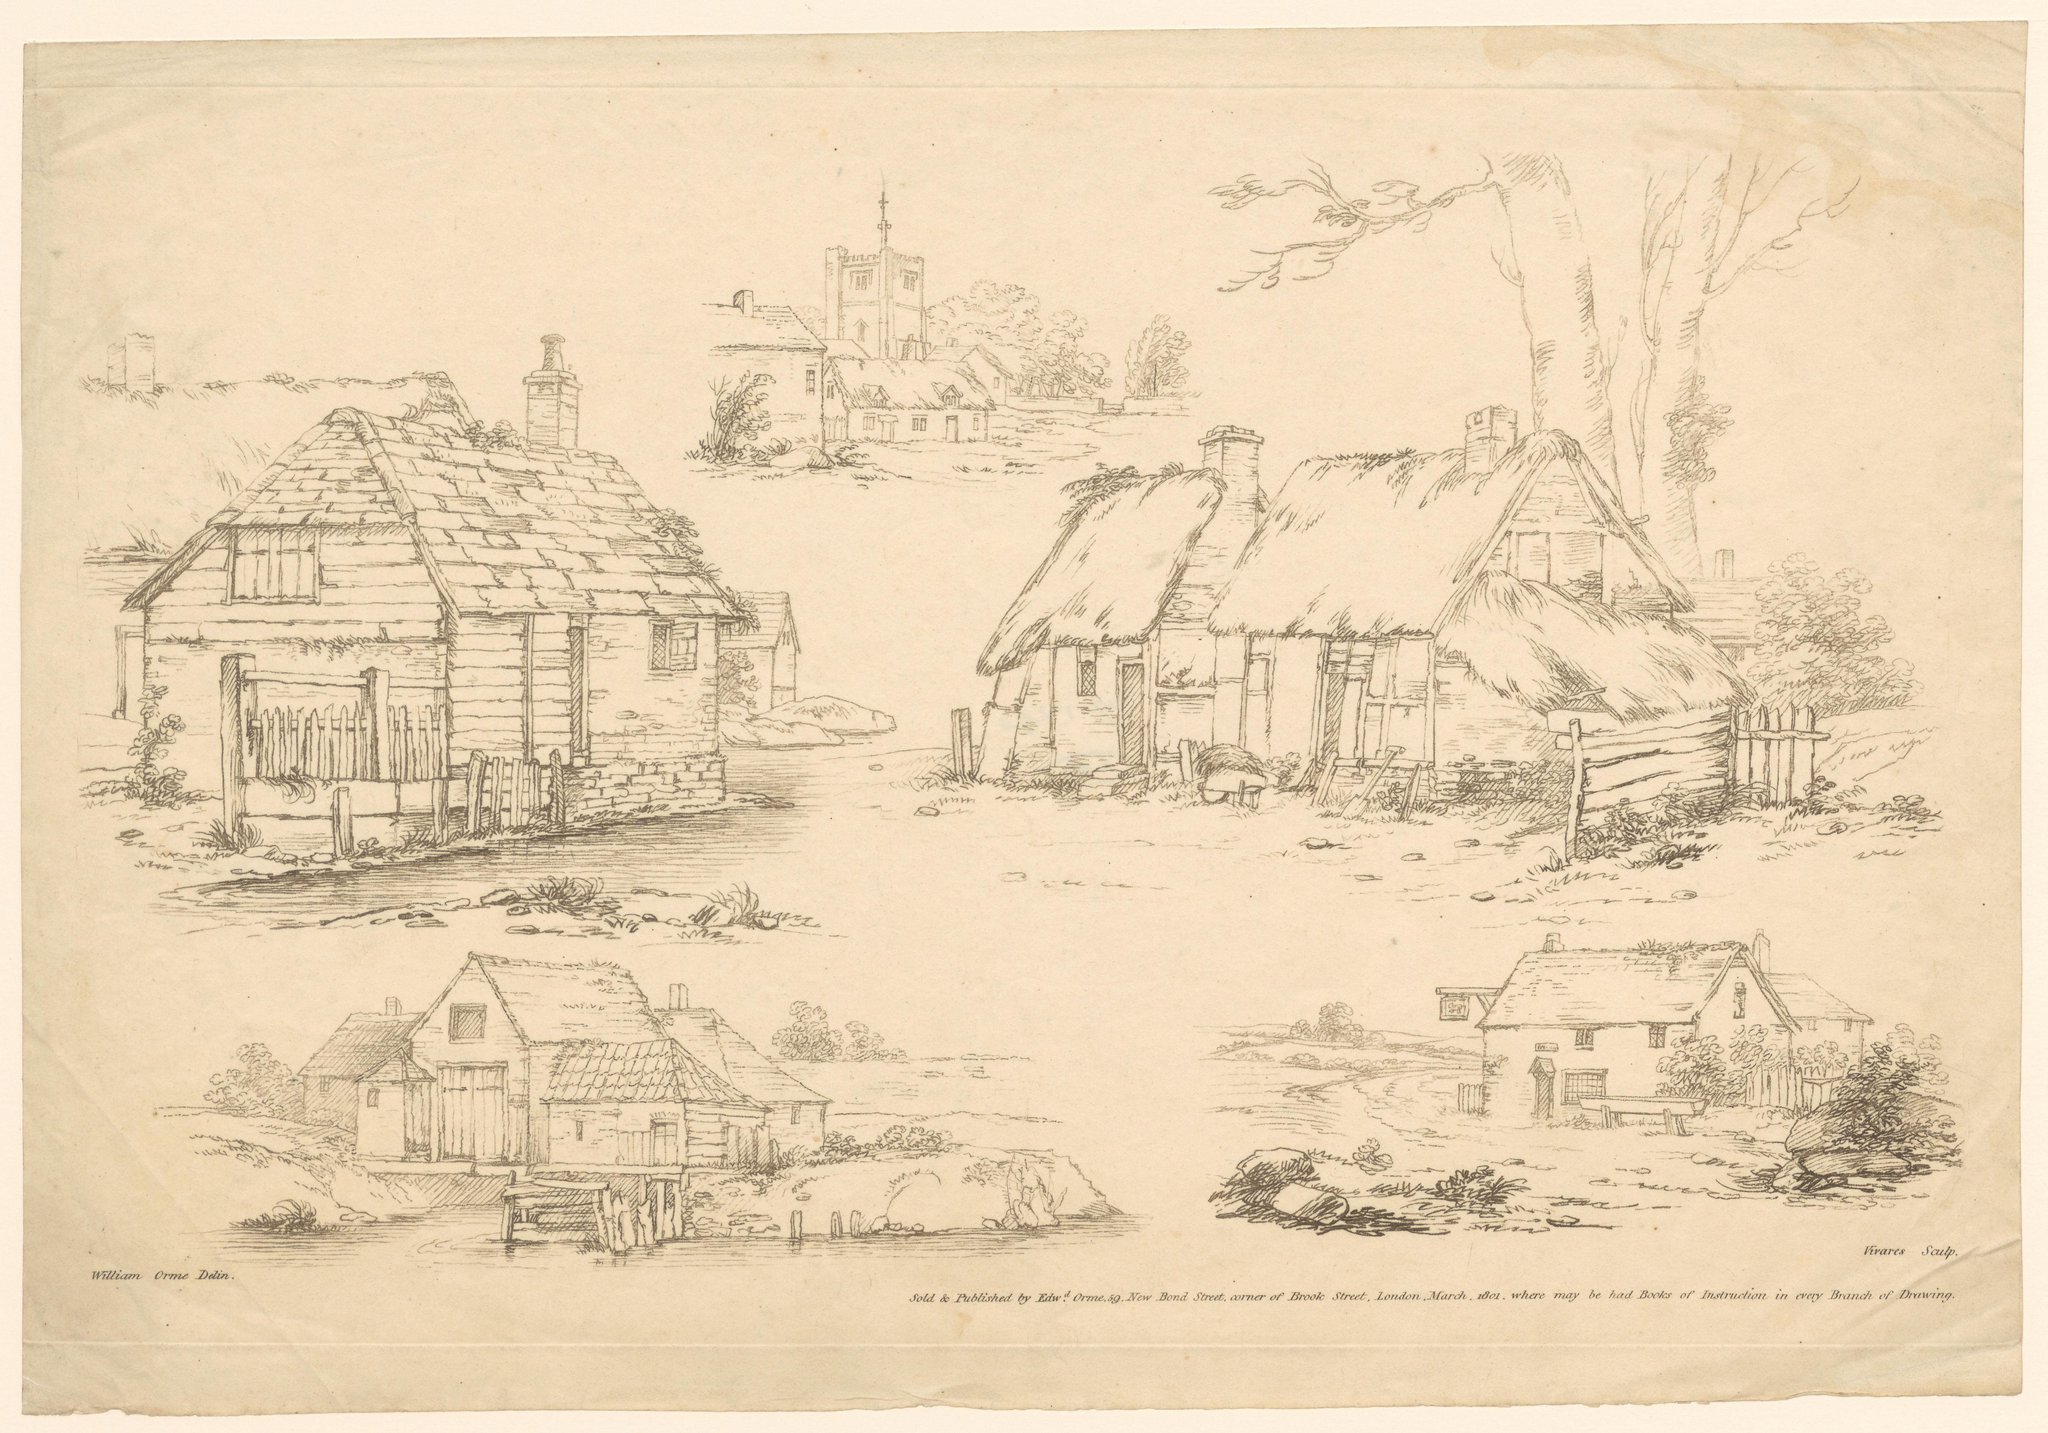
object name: print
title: Vijf dorpshuizen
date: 1801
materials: paper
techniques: etching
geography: london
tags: prospect of village, silhouette of village, farm or solitary house in landscape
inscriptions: collector's mark: Lugt 2228